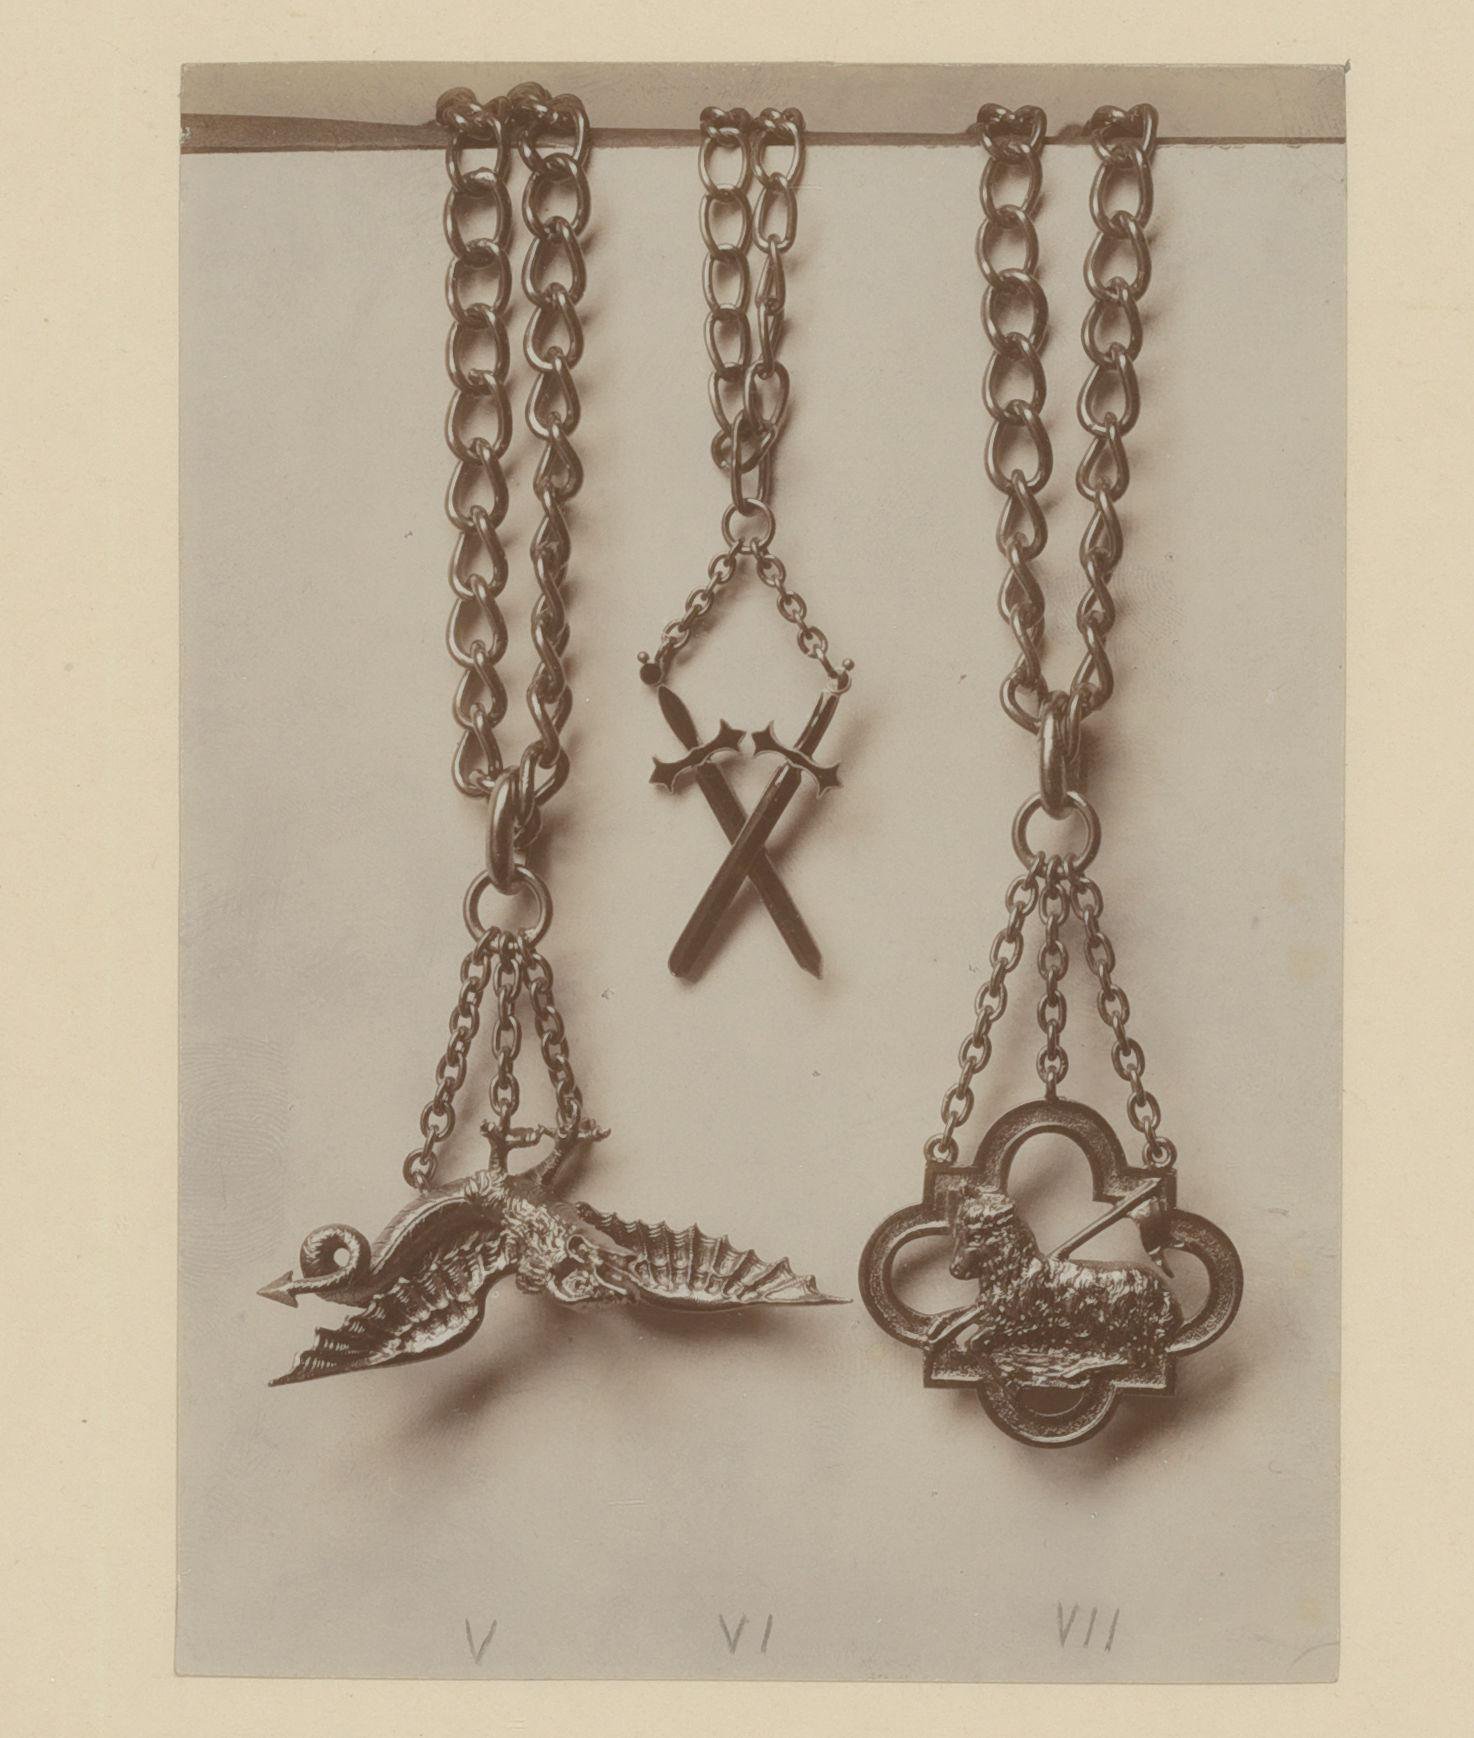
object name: photograph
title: Replica van drie ridderorden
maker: jean jacques antoine van winsen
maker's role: fotograaf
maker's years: 1851-1927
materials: paper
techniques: albumen print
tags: knighthood order, utrecht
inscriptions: stamp, collector's mark: Lugt 1641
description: Replica van drie ridderorden, de Orde van de Draak, de orde van Zwaard van Livonië en de Johanniterorde. Gemaakt door Koninklijke Utrechtse Fabriek van Zilverwerken C.J. Begeer ter gelegenheid van de Ridderhofspelen gehouden tussen 24 en 26 juni 1896 in Utrecht ter gelegenheid van het 52e lustrum van de Universiteit. Het thema van de Ridderhofspelen is het Ridderhofspel te Wenen in 1560. Onderwerpsrubrieken binnen de Atlas Zeden en Gewoonten: Onderwijs en Wetenschappen, Studentenleven.